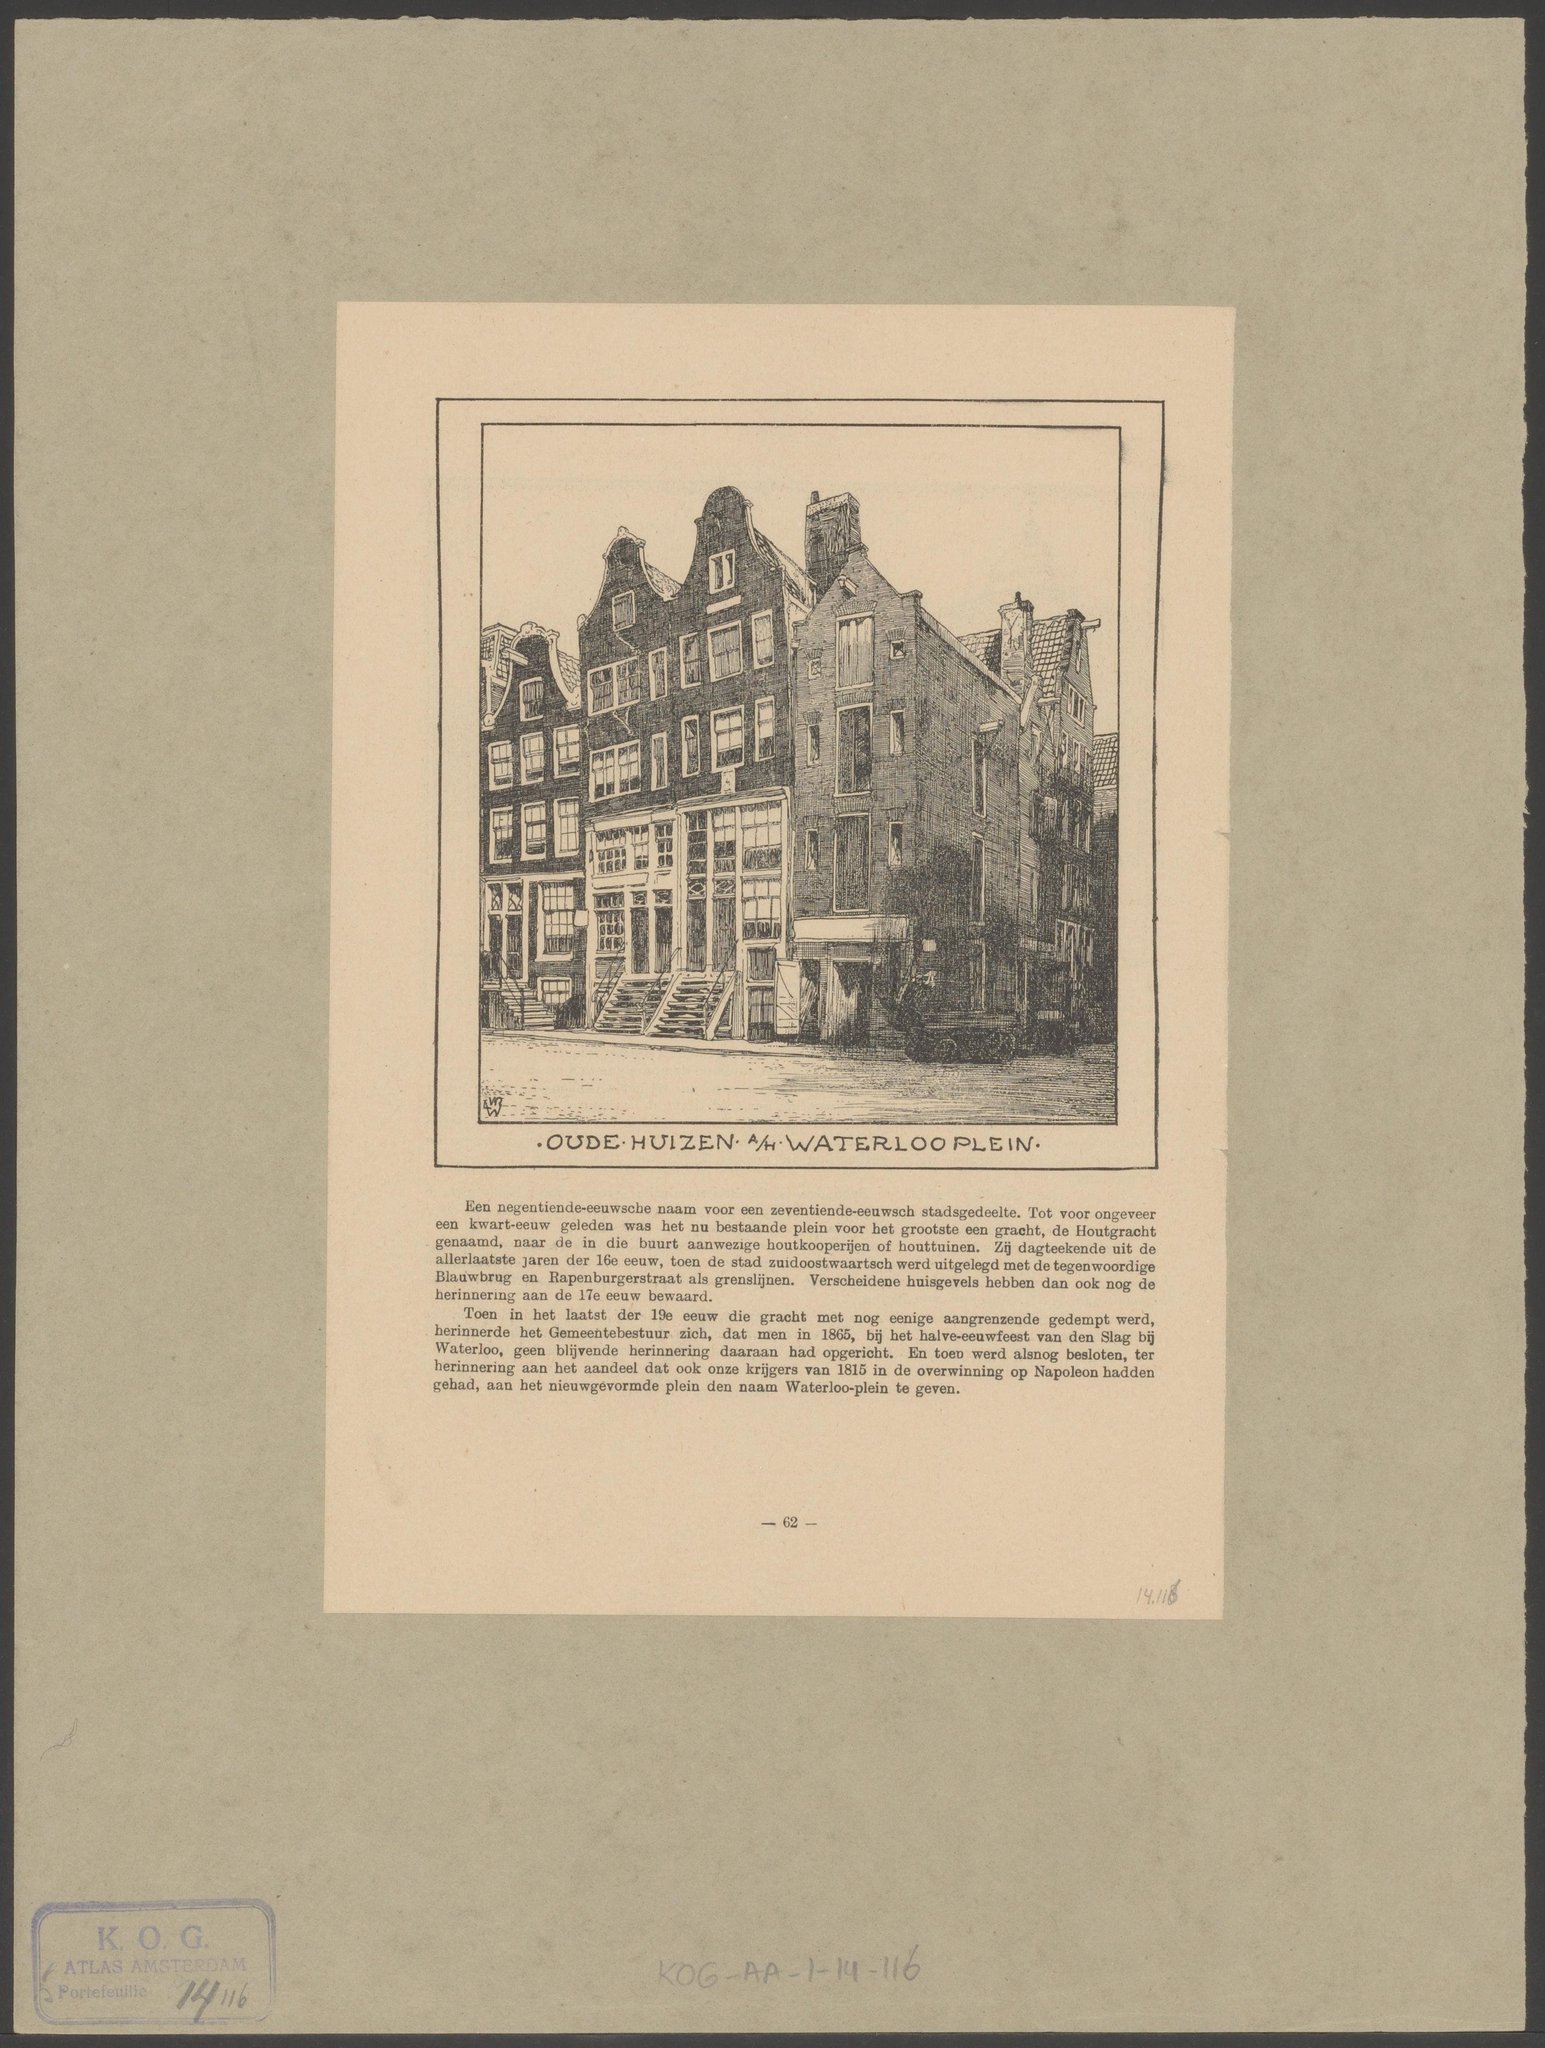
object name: photomechanical print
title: Oud-Amsterdam 100 Stadsgezichten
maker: willem wenckebach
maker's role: designer, draughtsman, painter, print maker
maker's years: 1860-1937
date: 1870-1923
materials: paper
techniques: letterpress printing, line block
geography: amsterdam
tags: square, place, circus, etc., city-view in general; 'veduta', the usual house or row of houses, façade (of house or building)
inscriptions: collector's mark: ‘14.116’ Lugt 1641b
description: Onderwerpsrubriek binnen de Atlas Amsterdam: Waal (Kromme en Oude), Walenpleintje, Warmoesgracht, Warmoesstraat, Waterlooplein, Westerdoksdijk, Westermarkt, Weteringschans, Willemspark, Willemsstraat, Wittenburg, Wittenkade (de), Wittenstraat (de).